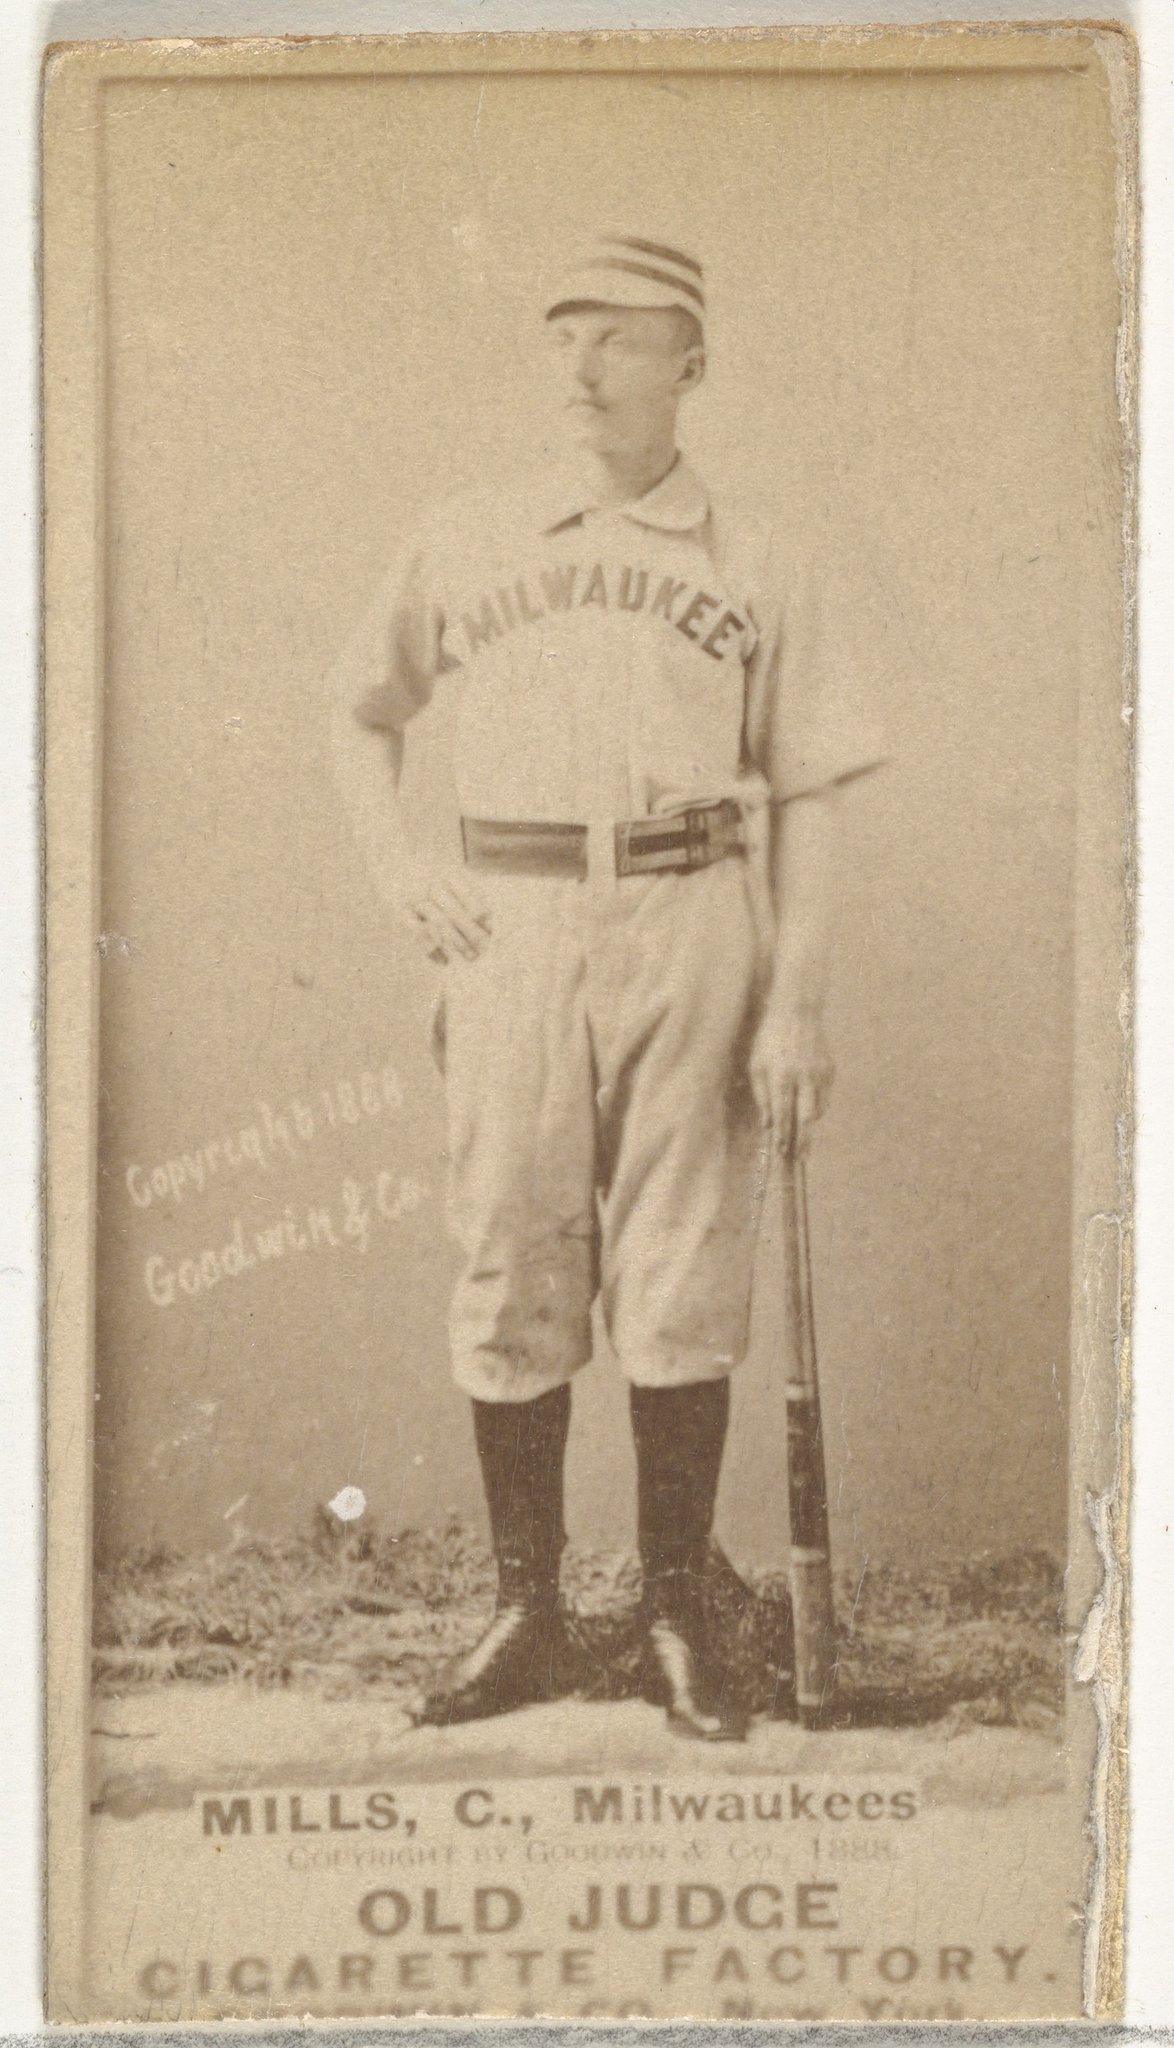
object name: baseball card, photograph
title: Lynn Mills, Catcher, Milwaukee, from the Old Judge series (N172) for Old Judge Cigarettes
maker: goodwin & company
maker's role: publisher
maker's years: 1850-1950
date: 1888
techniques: albumen silver print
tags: men,portraits,baseball,athletes